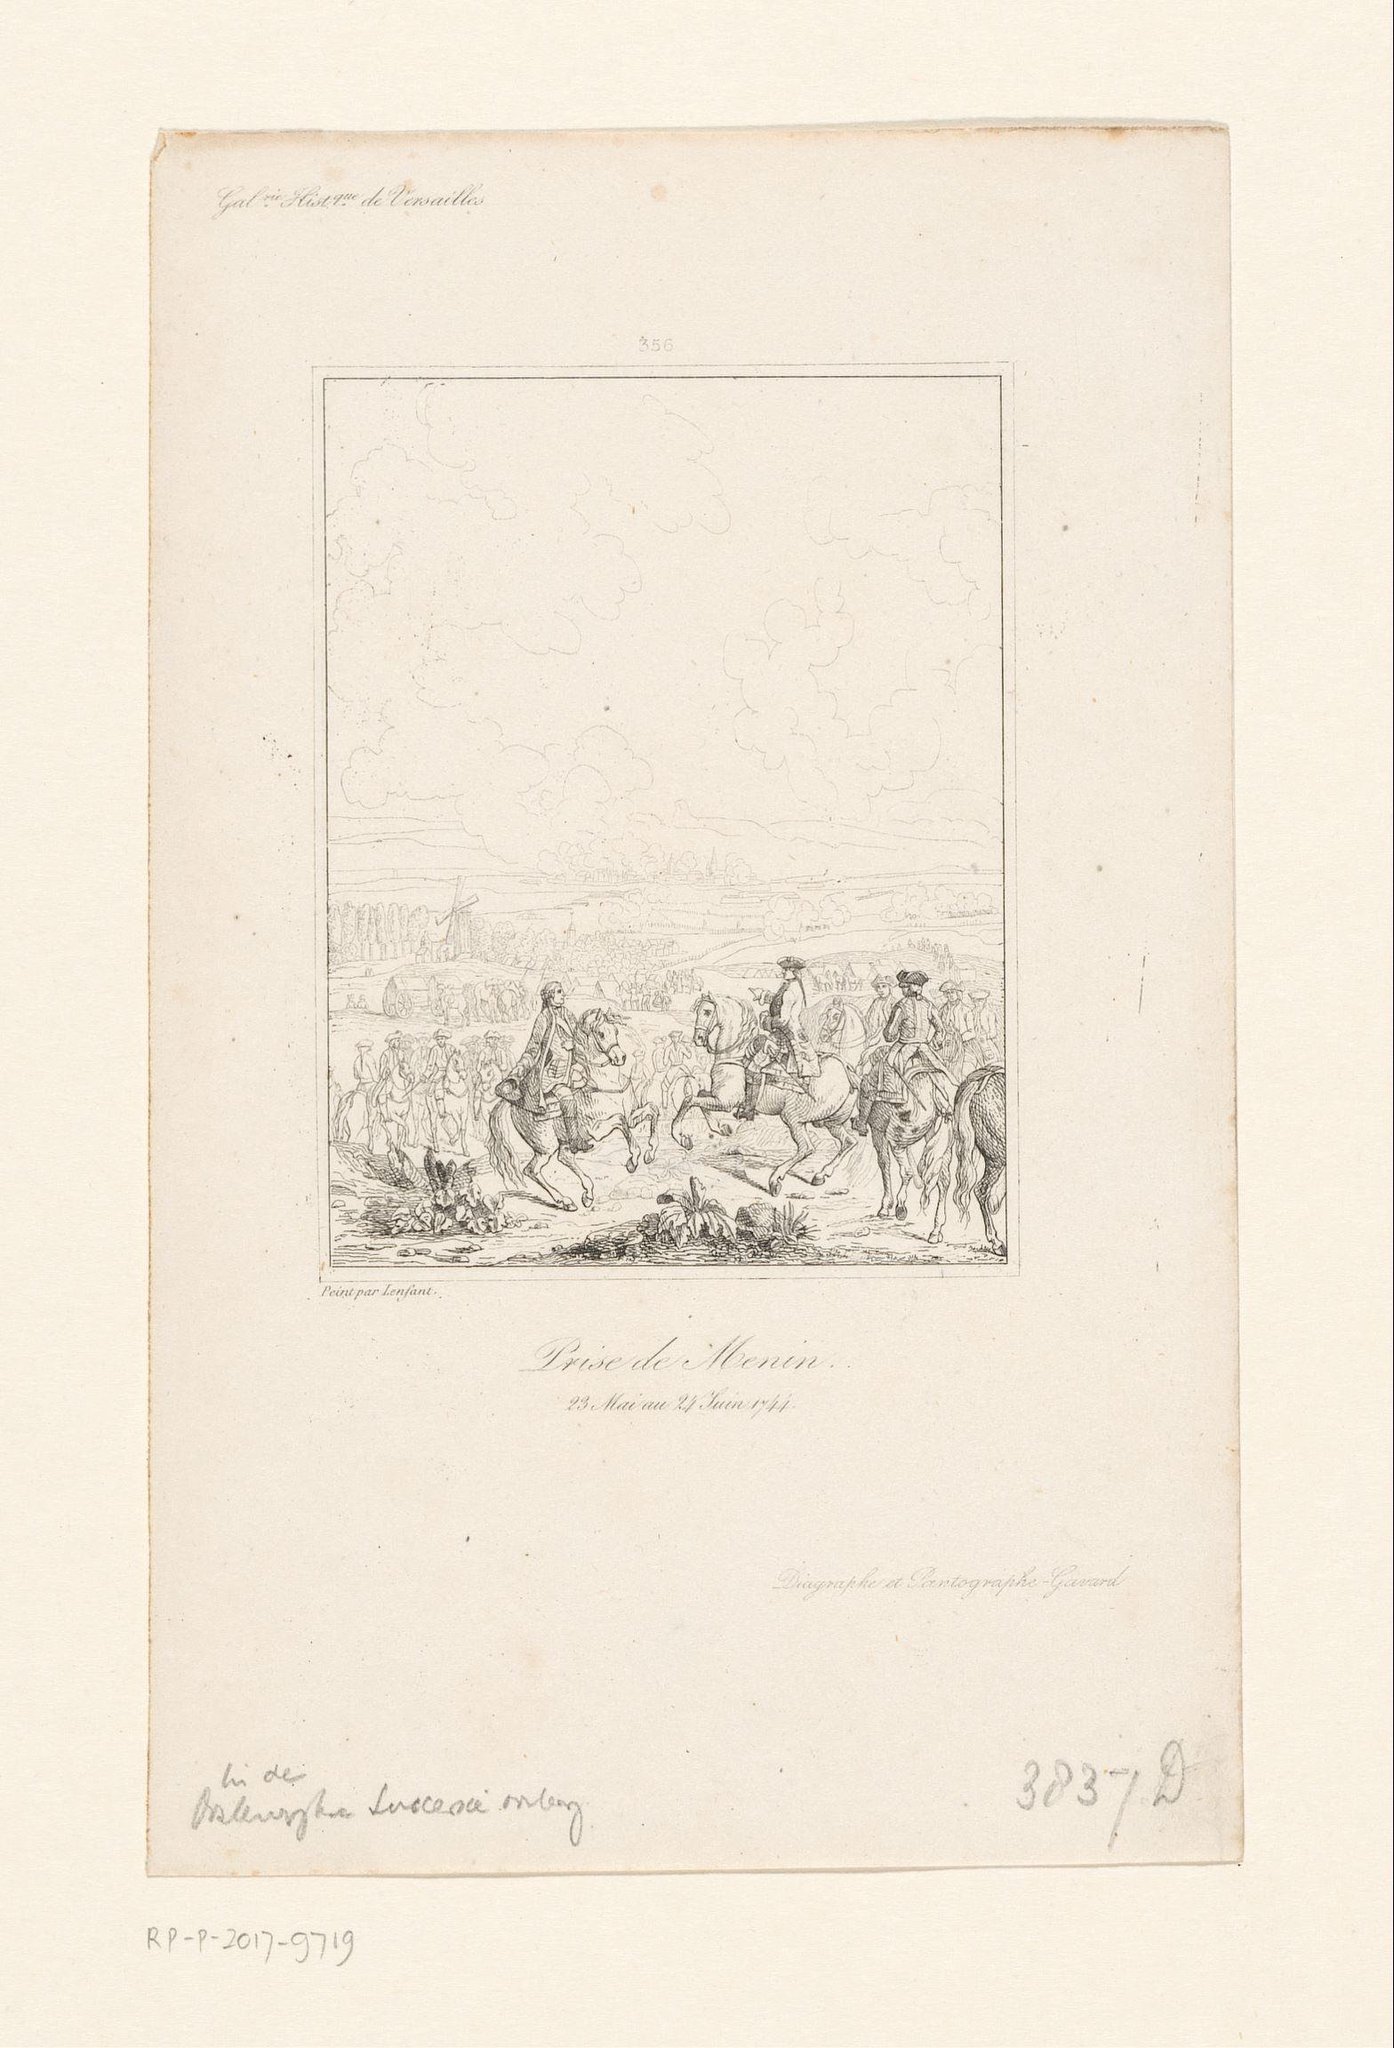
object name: print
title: Prise de Menin. 23 Mai au 24 Juin 1744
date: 1835-1840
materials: paper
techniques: etching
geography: northern netherlands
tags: capture of city (after the siege)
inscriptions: collector's mark: Lugt 2228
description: Gebruikt als illustratie in: C. Gavard, Galeries historiques de Versailles, collection de gravures réduites d'après les dessins originaux du grand ouvrage, Parijs 1840, nr. 356. Op de prent vermeld: Diagraphe et Pantographe Gavard.